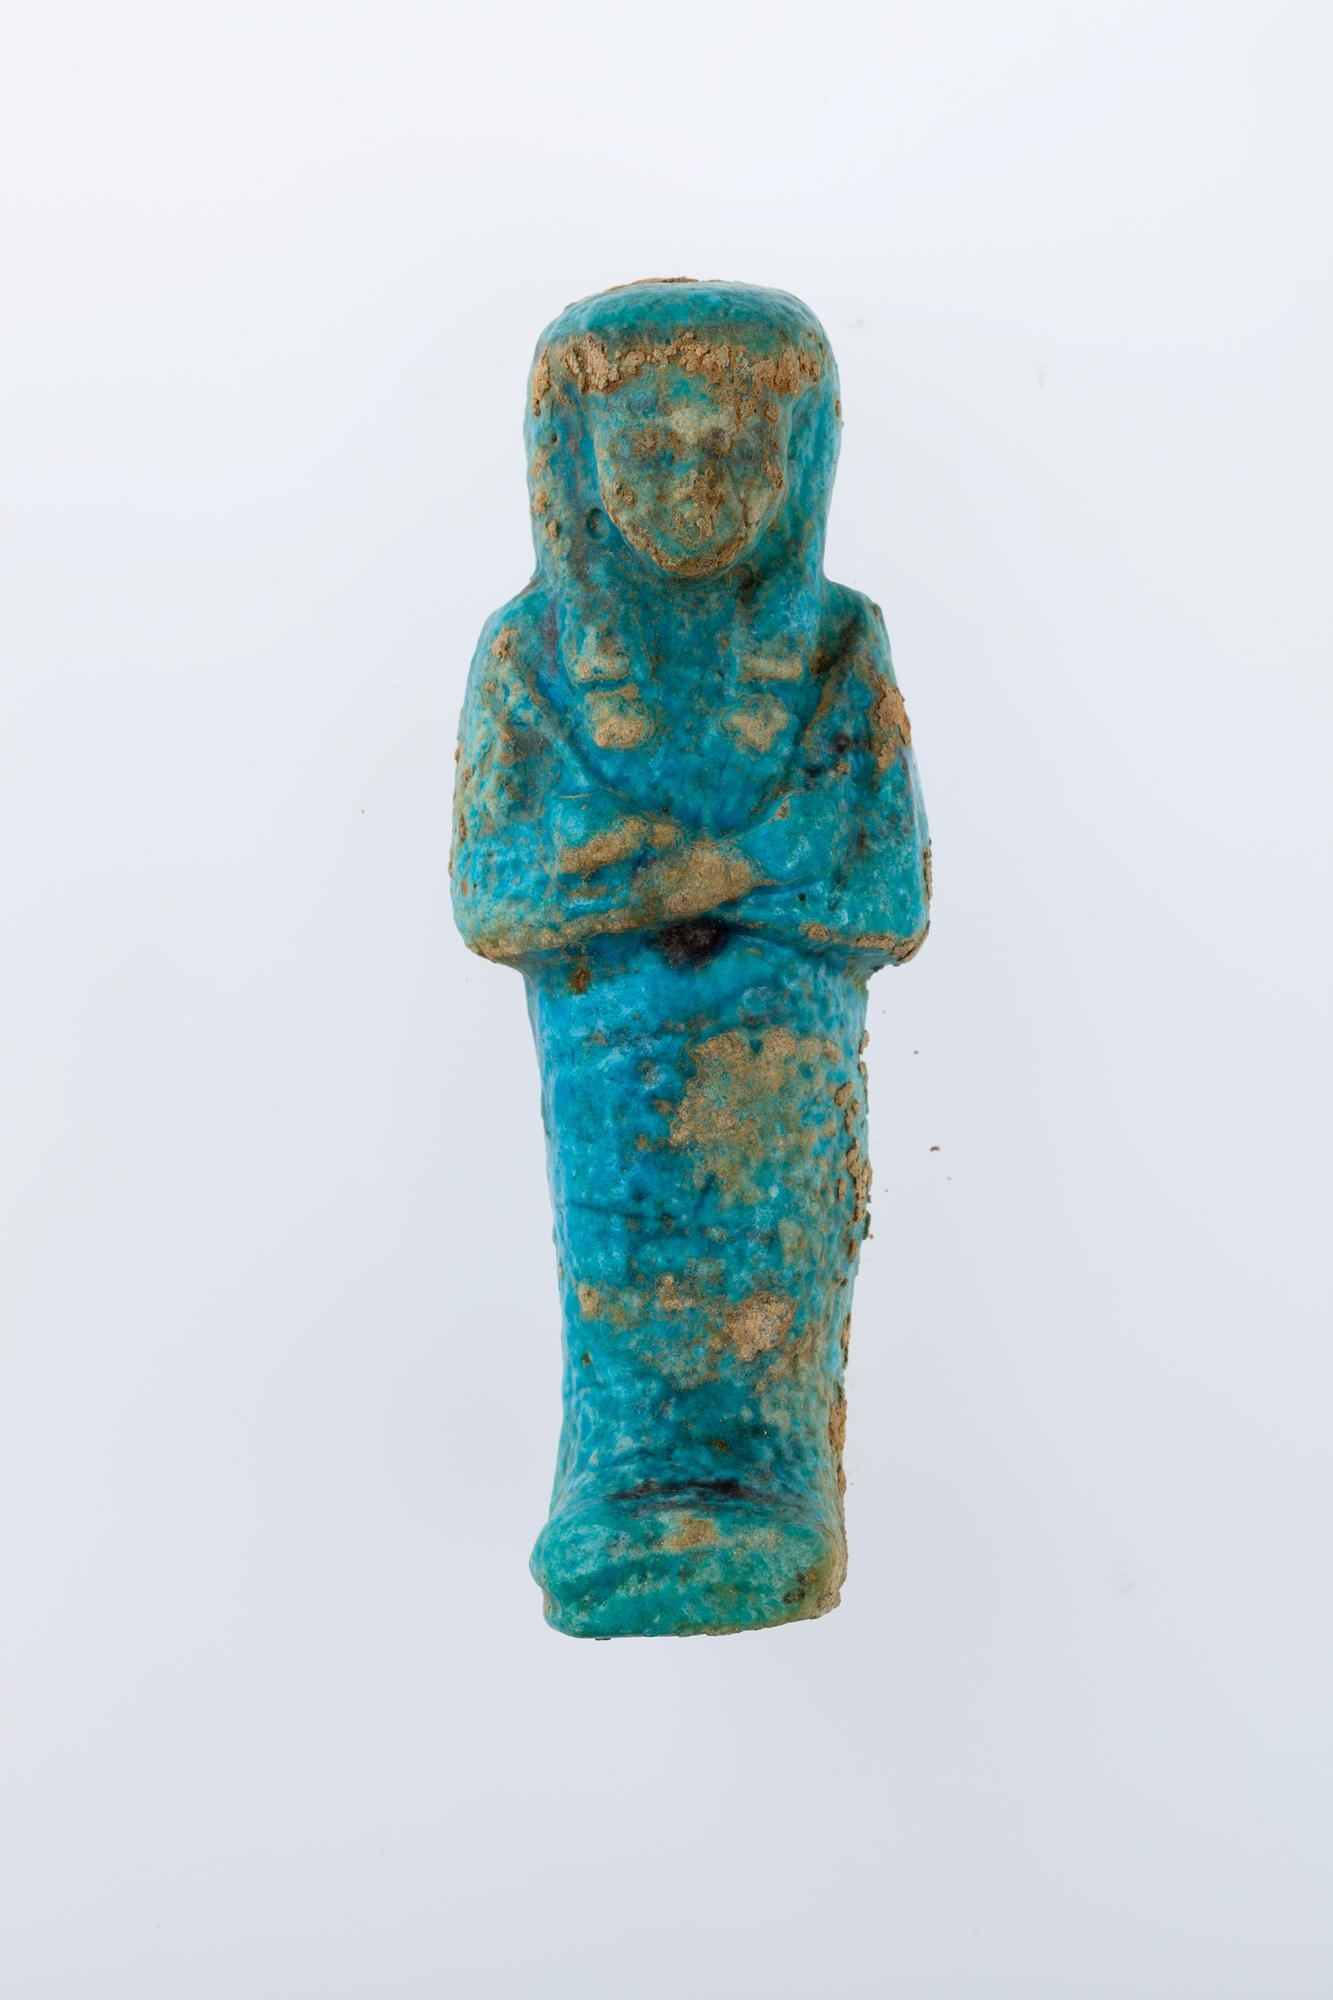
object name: shabti, henettawy c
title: Worker Shabti of Henettawy (C), Daughter of Isetemkheb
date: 990-970 BCE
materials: faience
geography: egypt